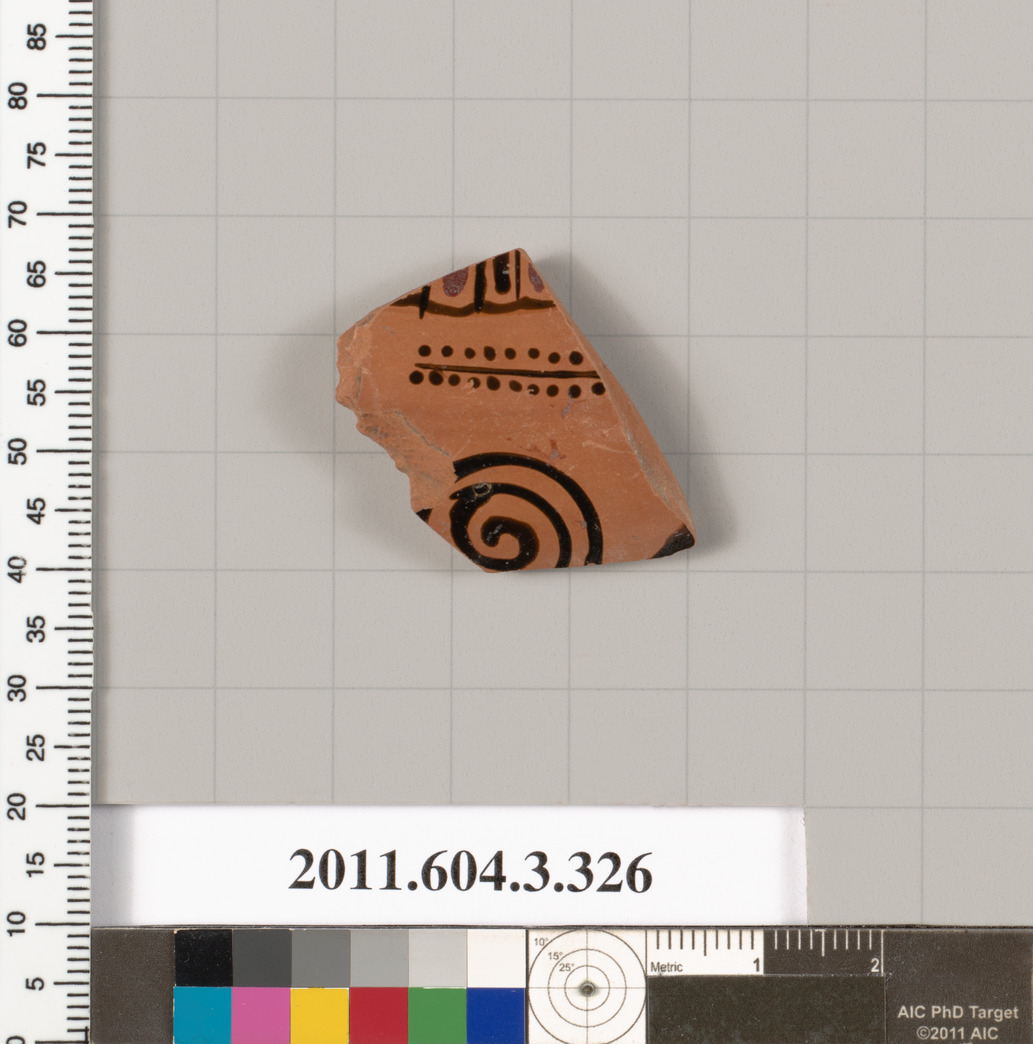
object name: neck amphora fragment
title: Terracotta fragment of a neck-amphora (jar)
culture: greek, attic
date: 540-530 BCE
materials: terracotta